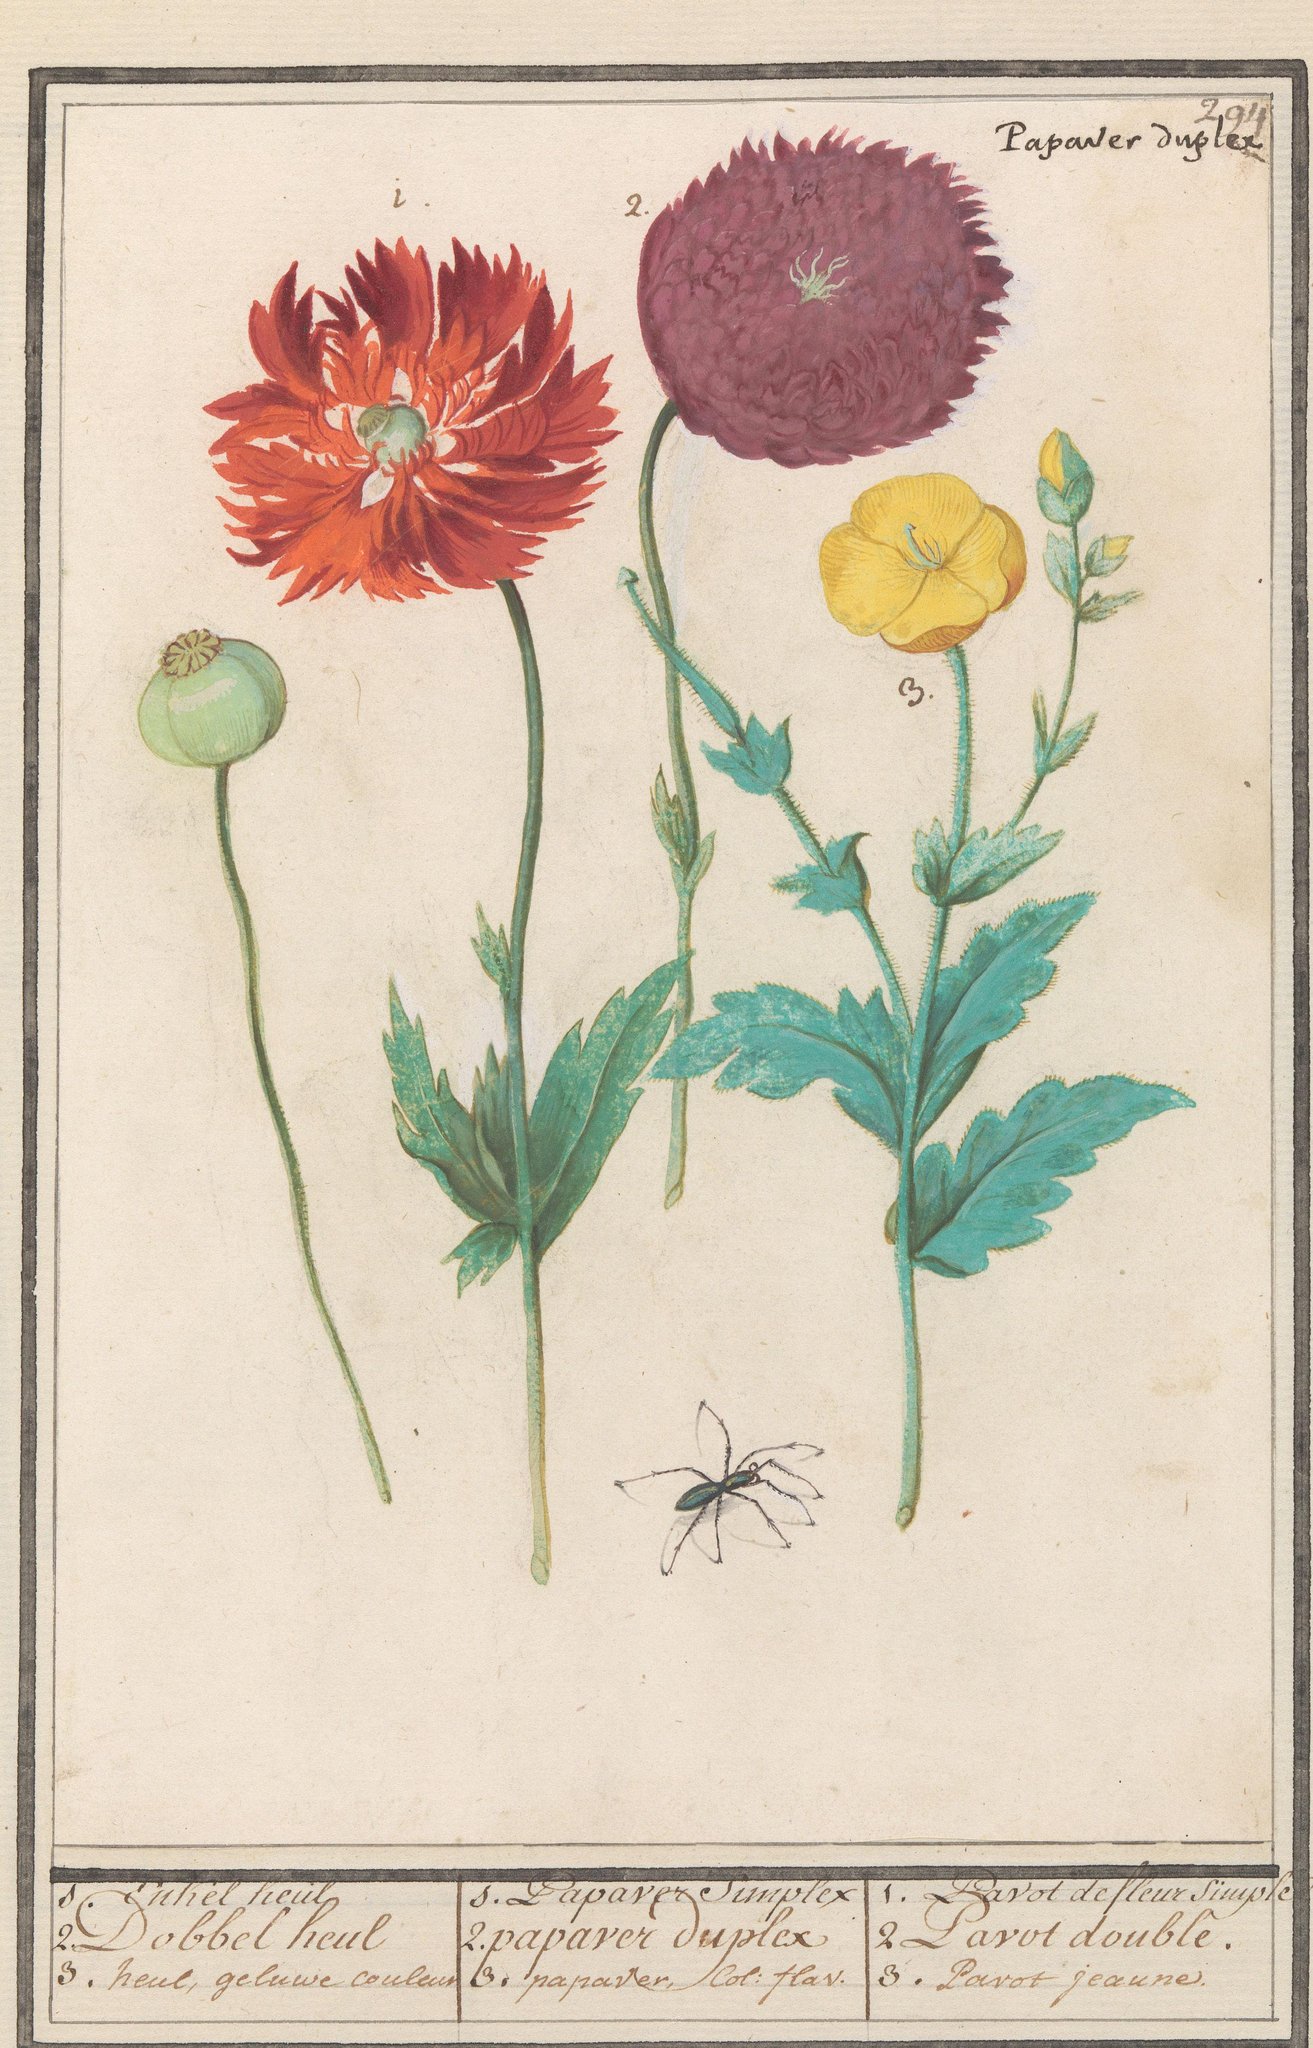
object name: drawing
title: 1. Enkel heul 2. Dobbel heul 3. heul, geluwe couleur / 1. Papaver Simplex 2. papaver duplex 3. papaver col: flav. / 1. Pavot de fleur simple 2 Pavot double. 3. Pavot jeaune.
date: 1596-1610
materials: chalk, paint, ink, paper, watercolor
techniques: brush, pen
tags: spiders, flowers: poppy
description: Drie klaprozen of papavers. Met een spin. Genummerd rechtsboven: 294. Hierbij ook de Latijnse naam. Onderdeel van het derde album met tekeningen van bloemen en planten. Tiende van twaalf albums met tekeningen van dieren, vogels en planten bekend rond 1600, gemaakt in opdracht van keizer Rudolf II. Met toelichting in Nederlands, Latijn en Frans.